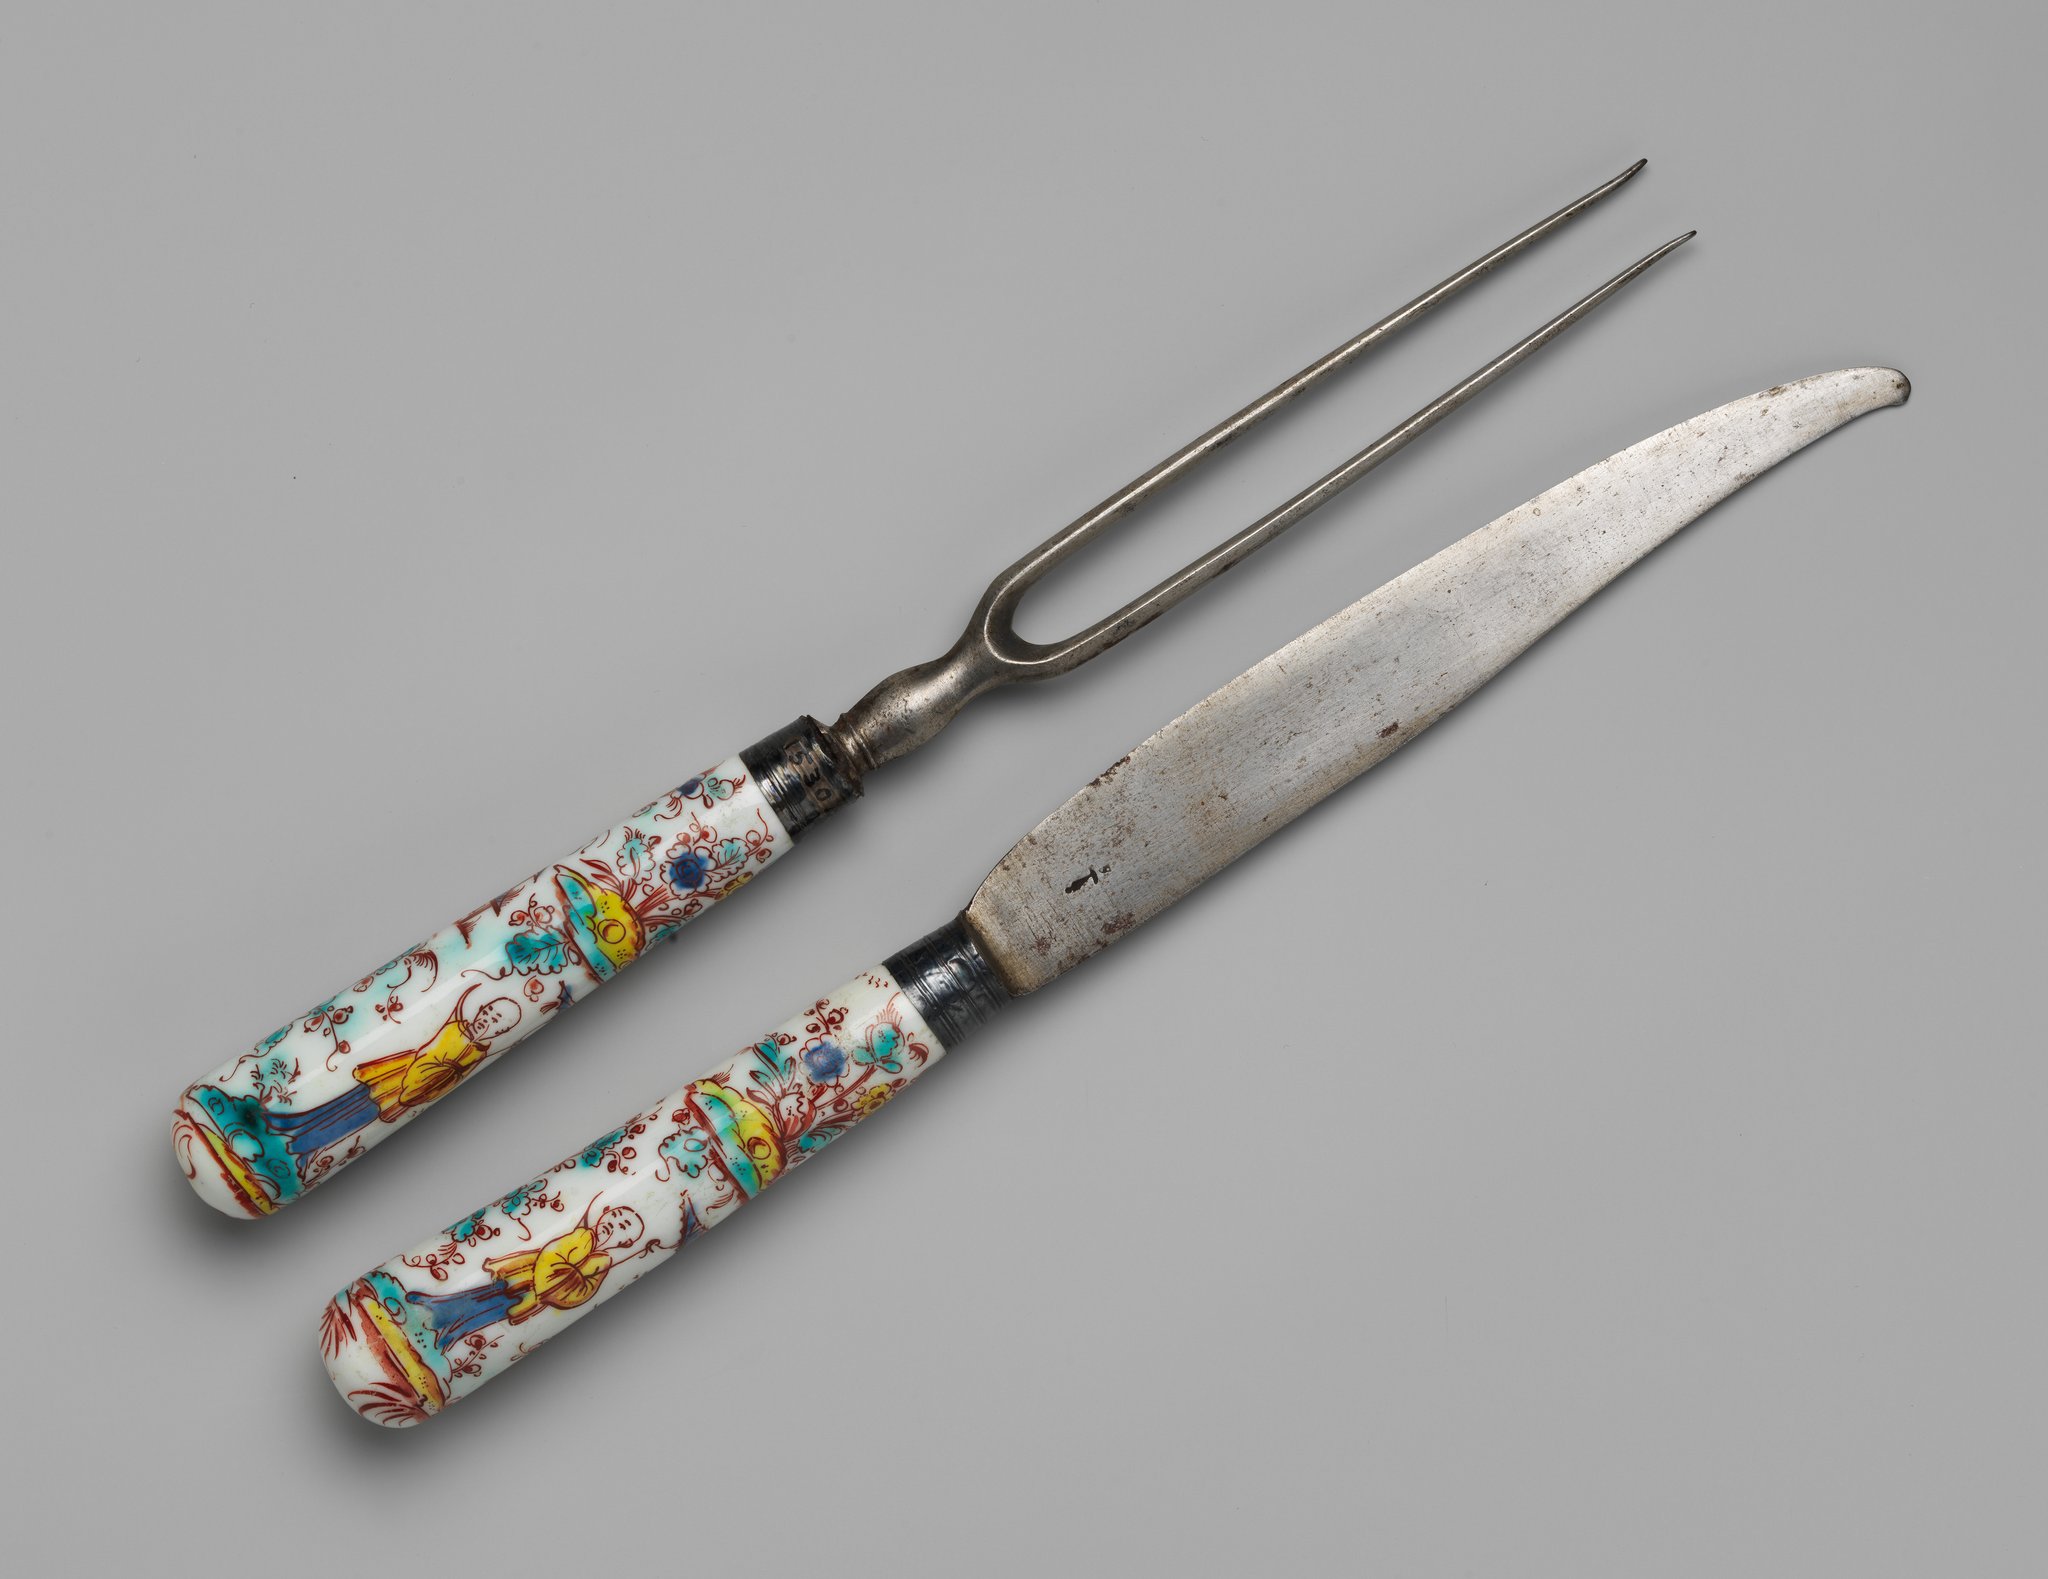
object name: knife and fork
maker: saint-cloud factory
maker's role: factory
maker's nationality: french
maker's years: 1693-1766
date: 1740-1750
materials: soft paste porcelain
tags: chinoiserie